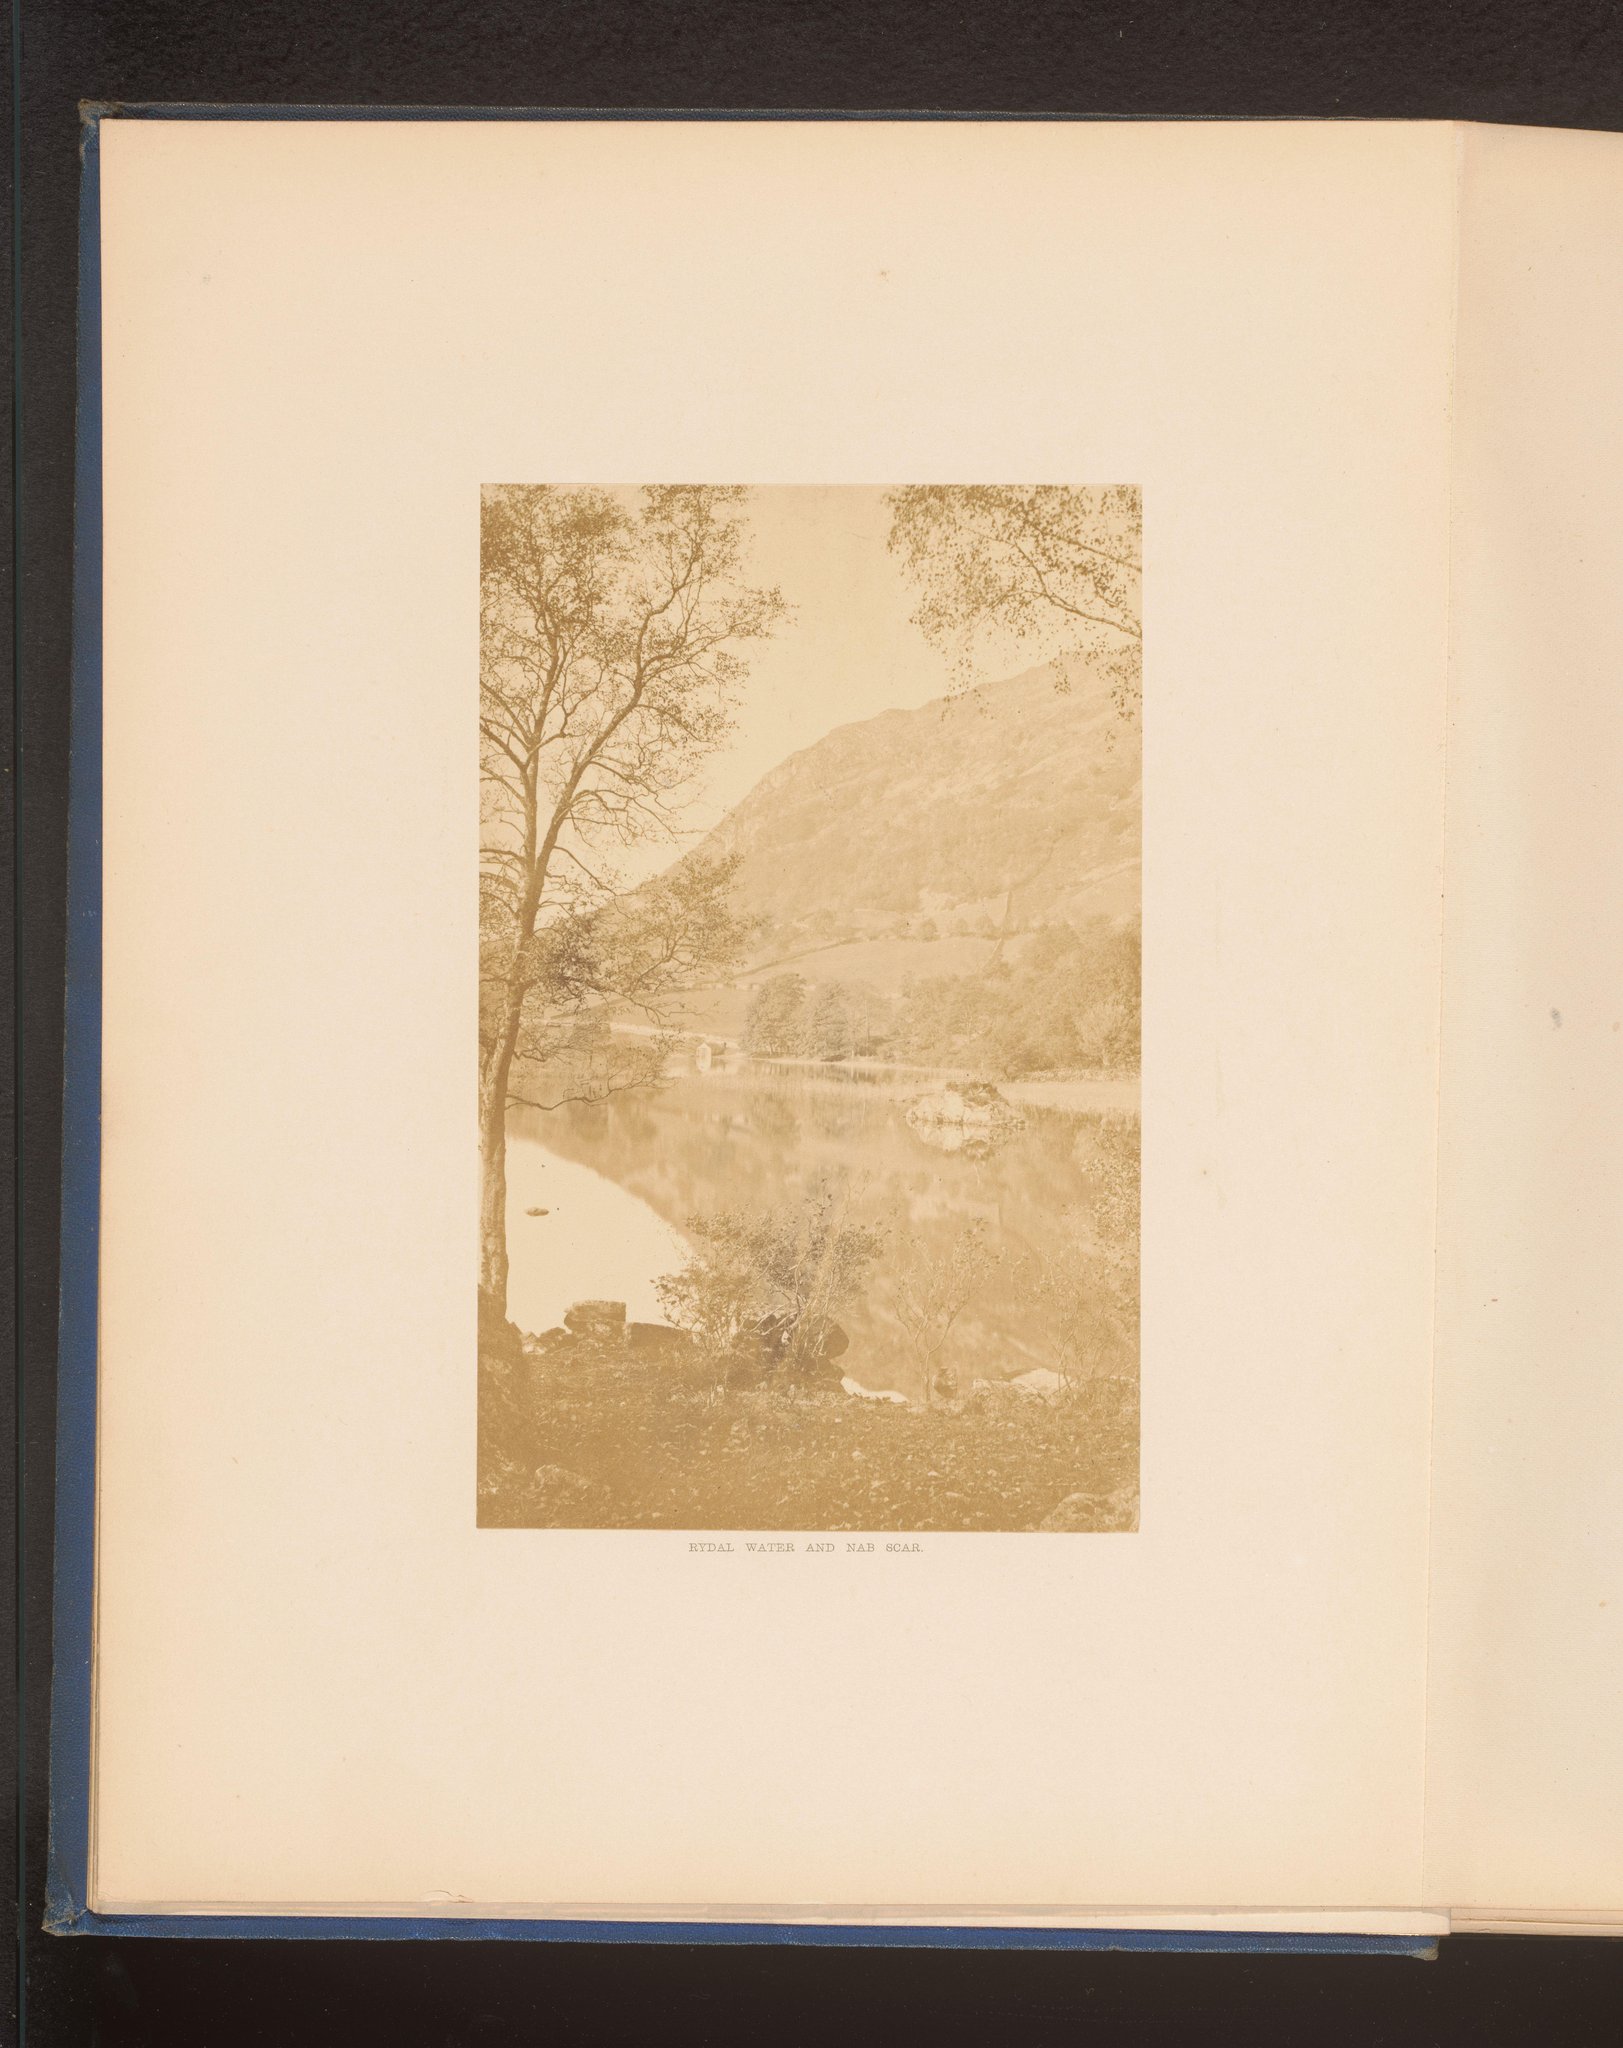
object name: photograph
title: Rydal Water and Nab Scar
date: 1857-1867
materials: photographic support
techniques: albumen print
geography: lake district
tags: (high) hill, lake